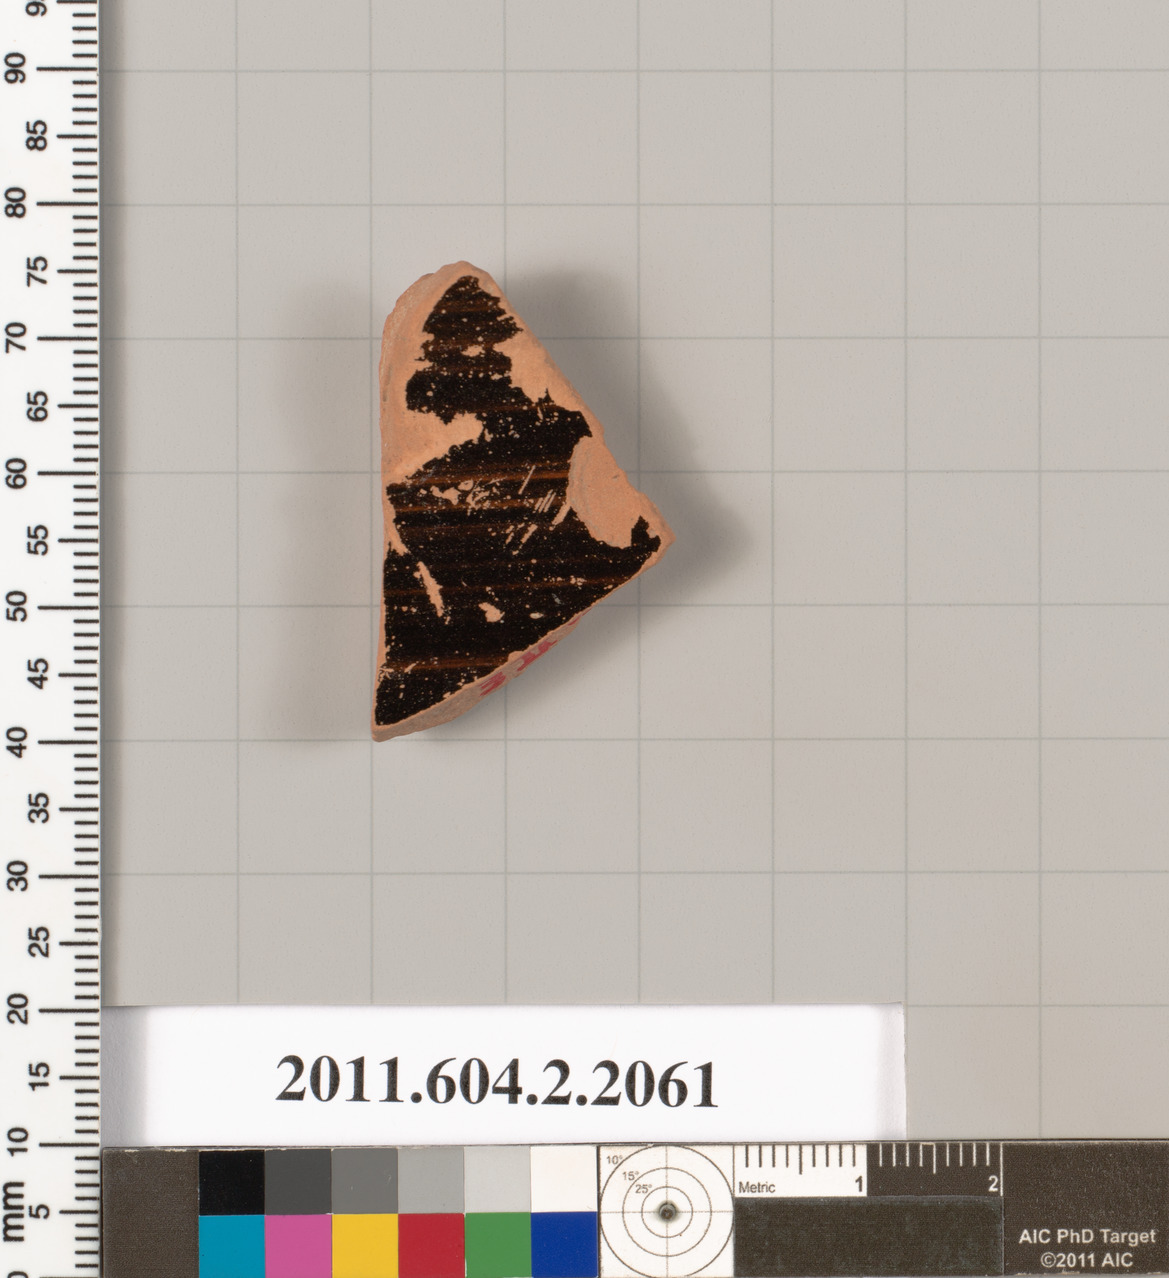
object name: krater fragment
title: Terracotta fragment of a krater (bowl for mixing wine and water)?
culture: greek, attic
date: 475-451 BCE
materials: terracotta